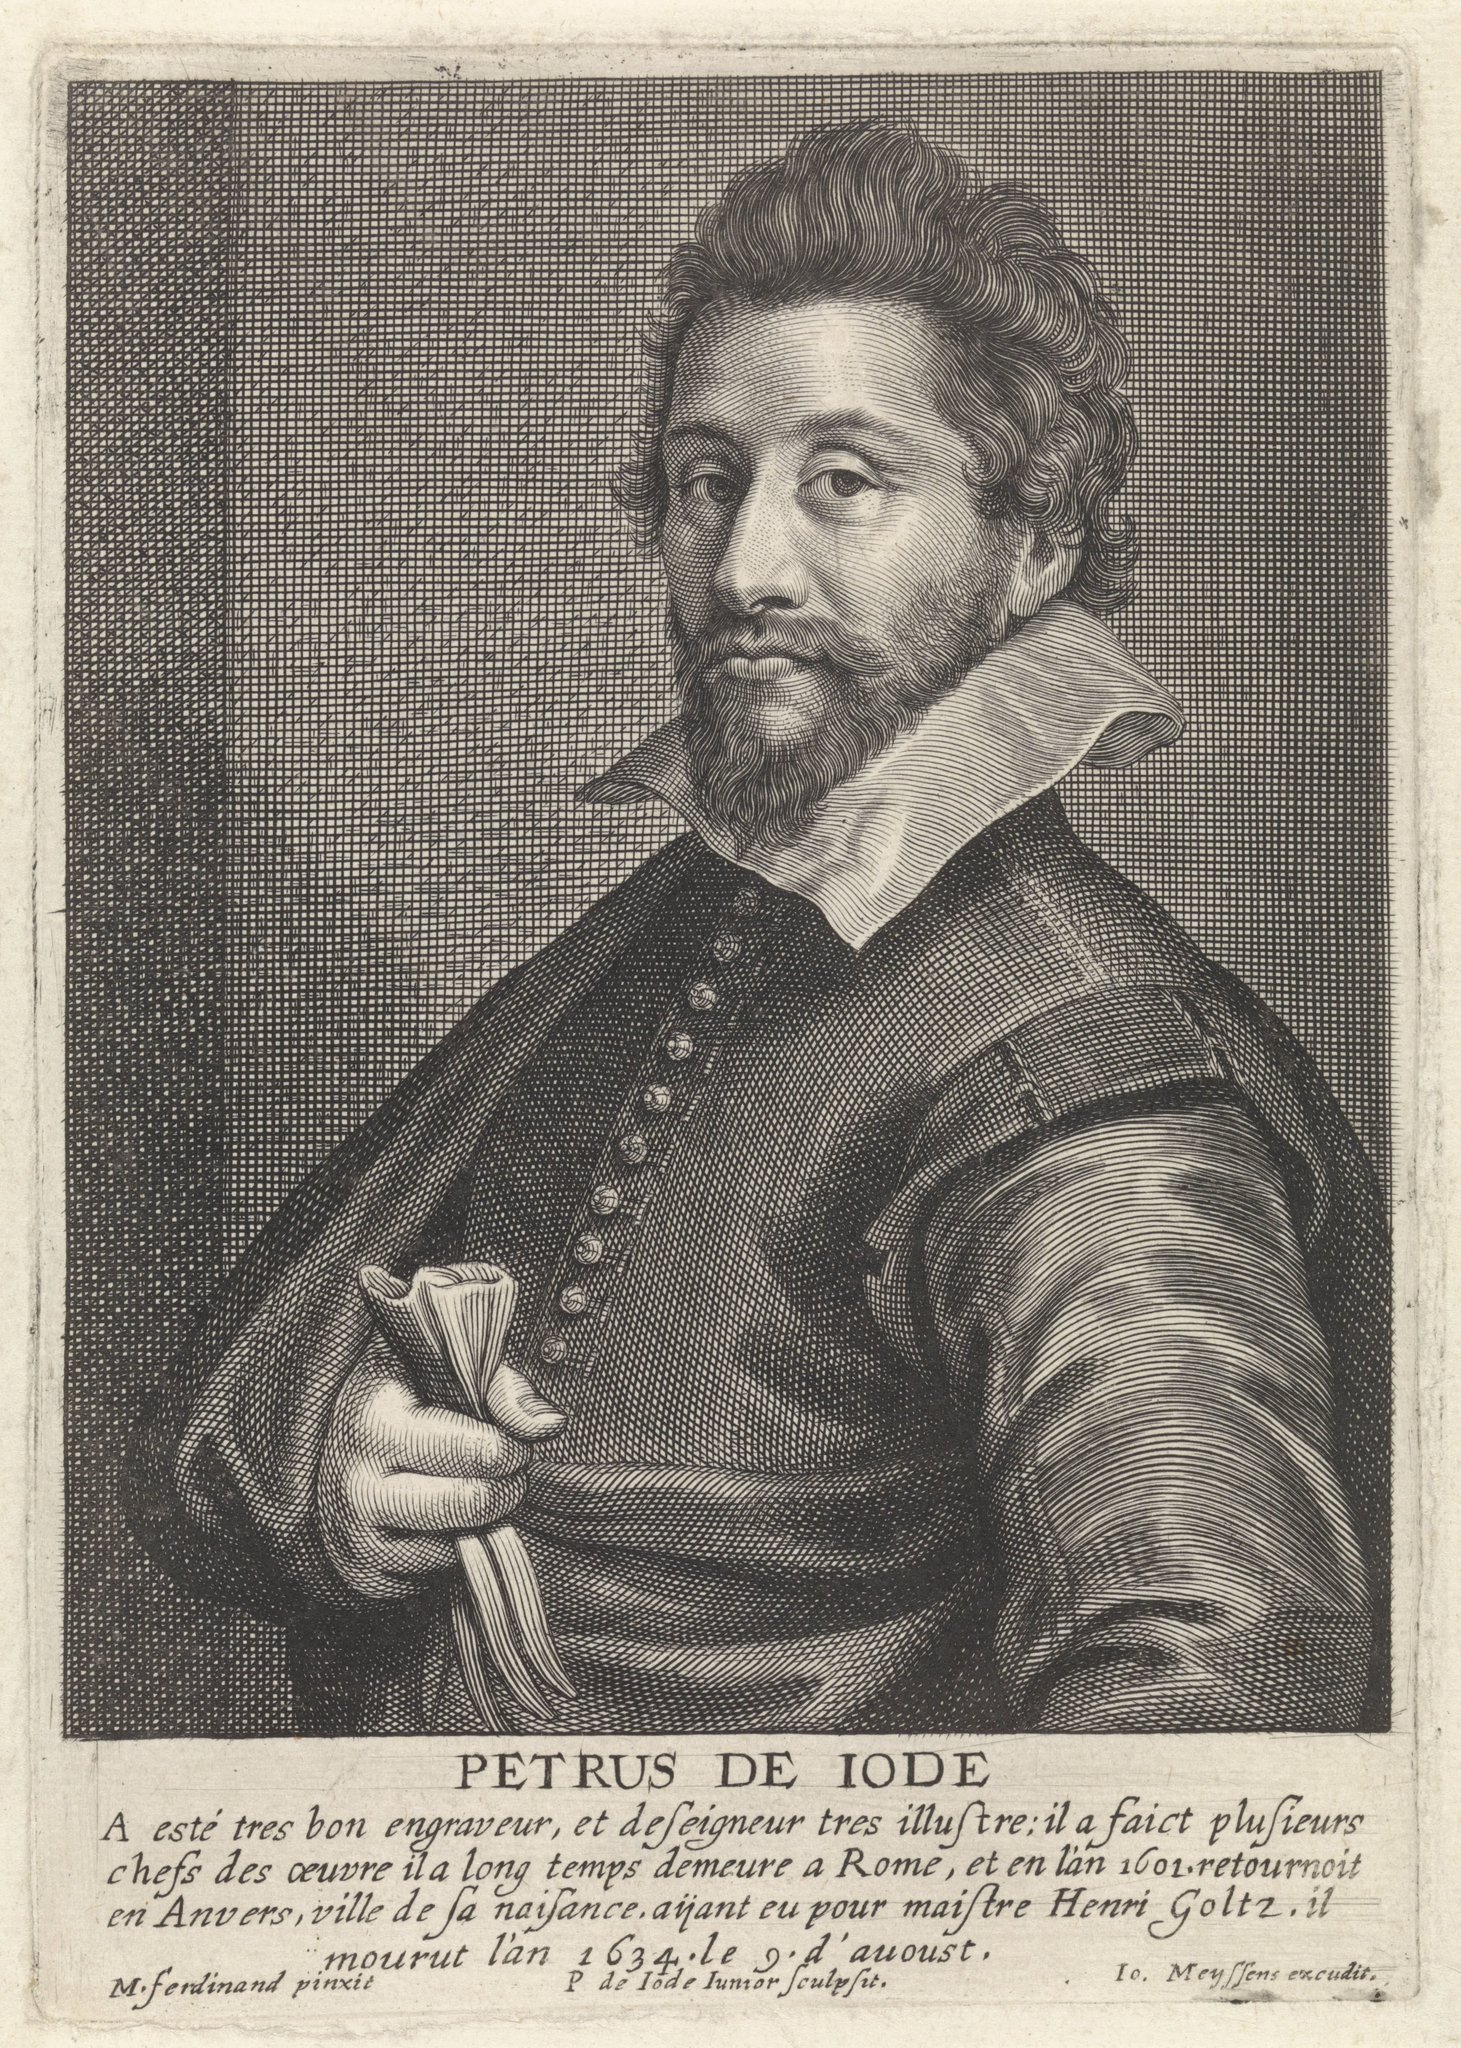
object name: print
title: Busteportret van Pieter de Jode (I)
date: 1628-1670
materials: paper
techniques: engraving, etching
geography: antwerp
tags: antwerp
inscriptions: inscription: ‘872’, collector's mark: Lugt 2228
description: Busteportret van de kunstenaar Pieter de Jode (I). In zijn rechterhand houdt hij een handschoen. In de marge de naam van de geportretteerde en een vierregelig onderschrift in het Frans.